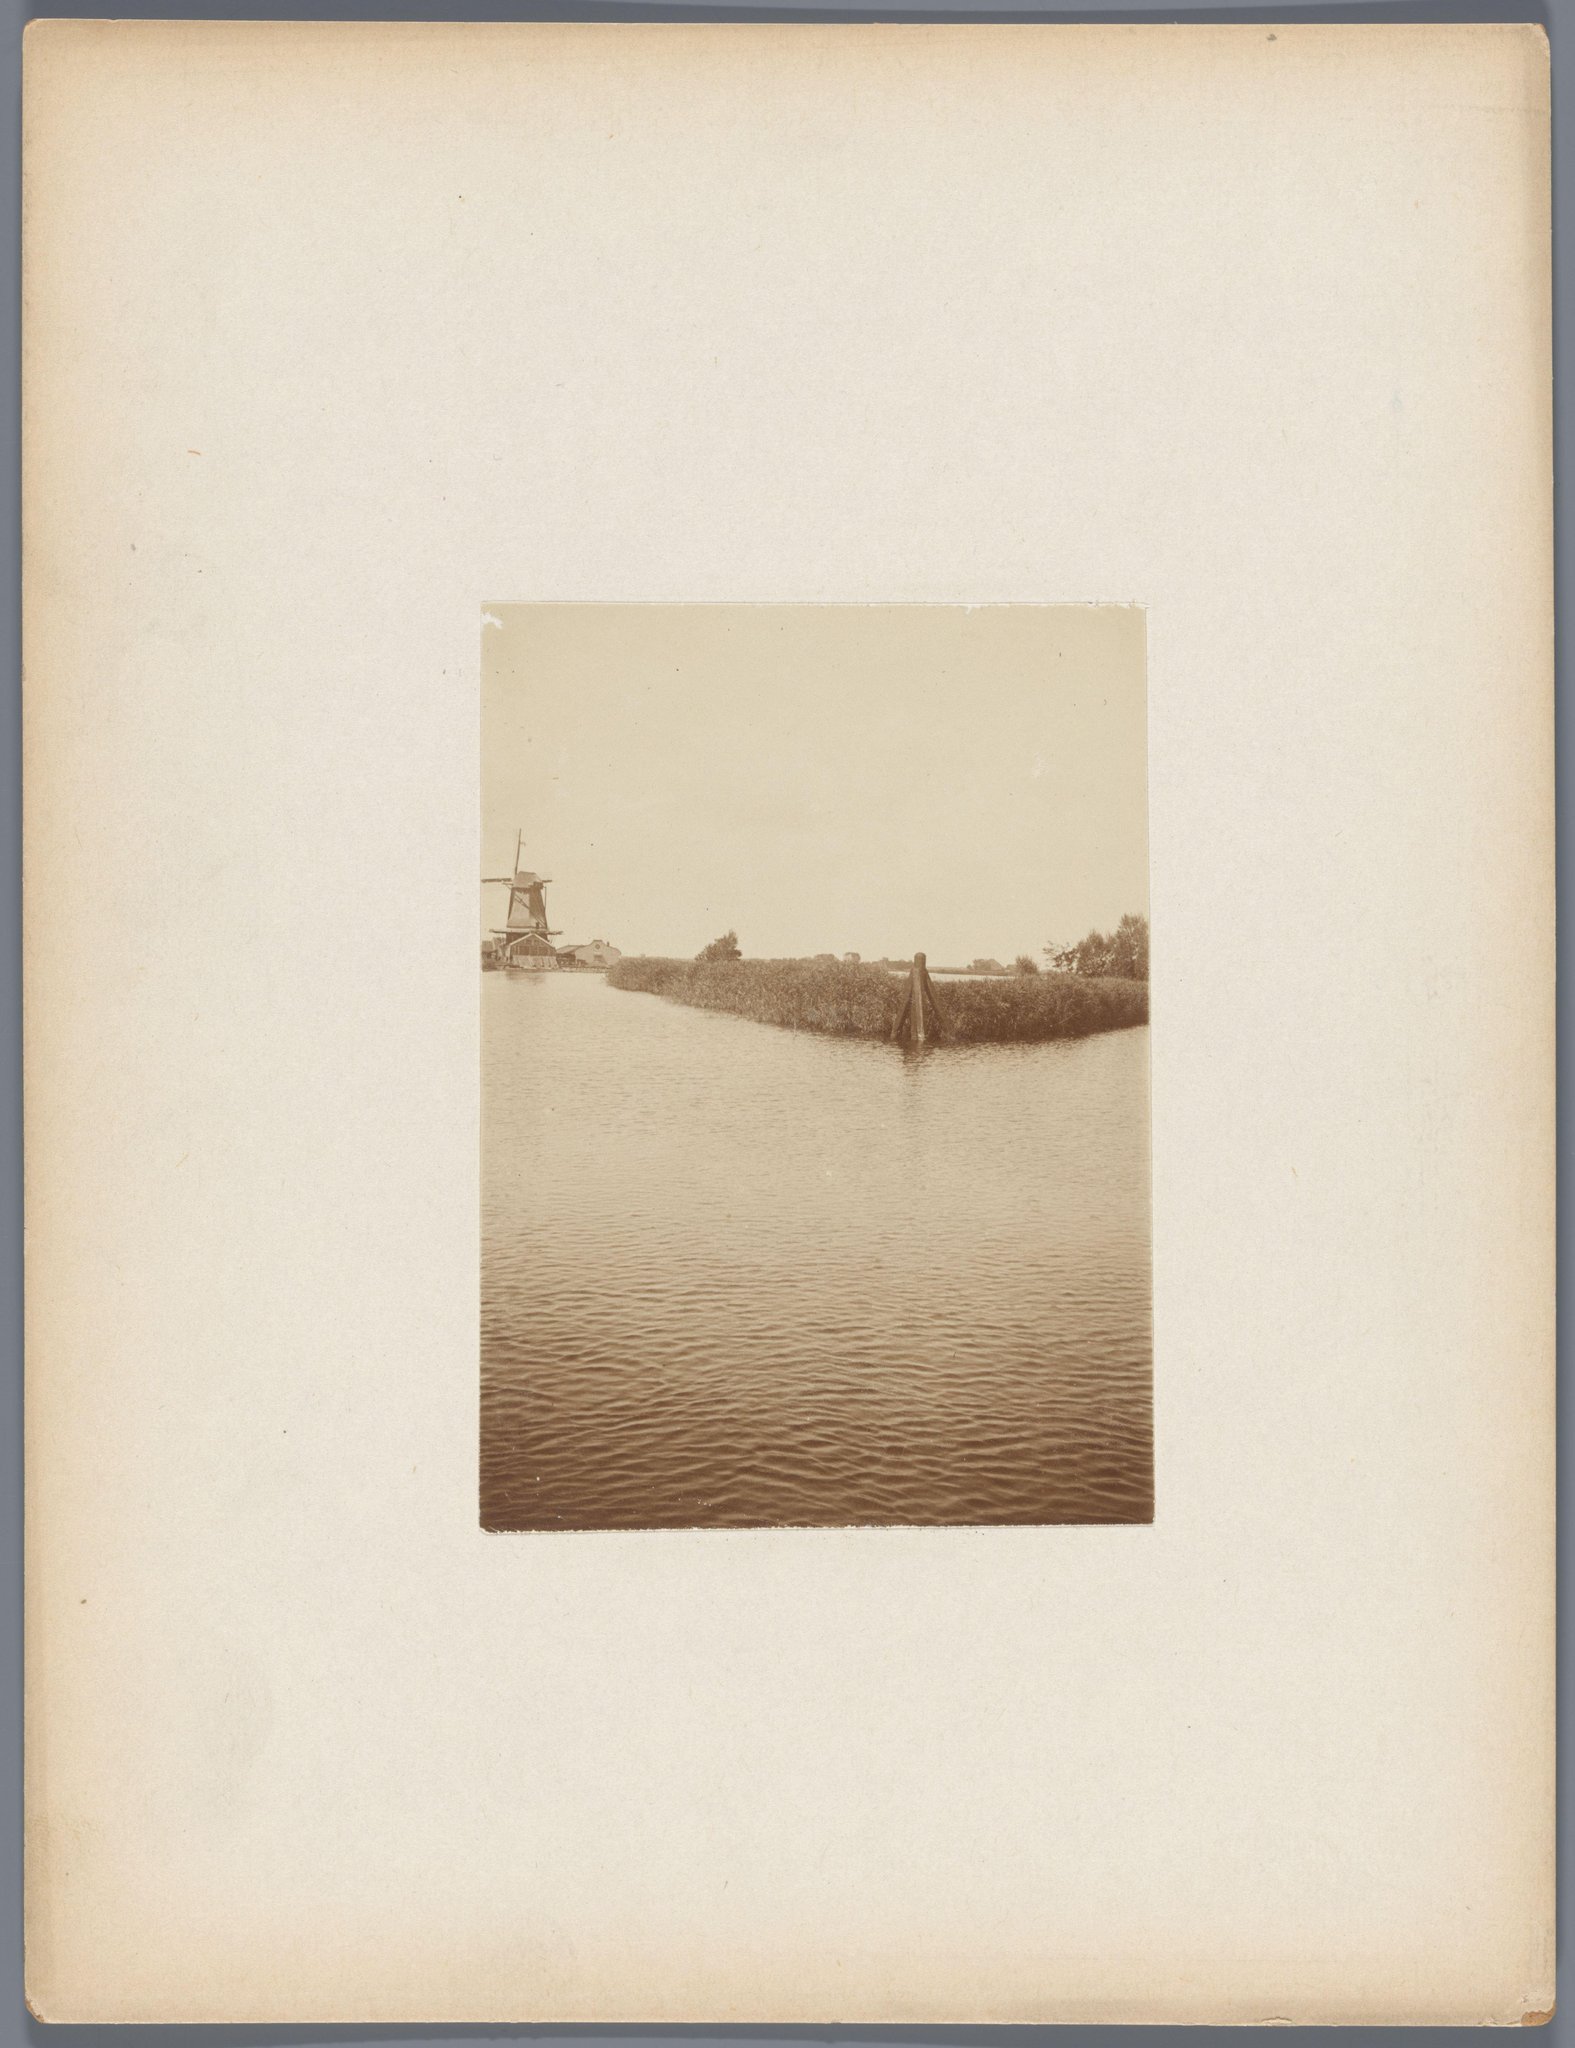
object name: photograph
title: Molen aan water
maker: Anonymous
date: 1907-1910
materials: cardboard, photographic support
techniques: collodion silver print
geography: netherlands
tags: windmill in landscape, netherlands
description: Gezicht over het water met een molen en een dukdalf. Onderdeel van het losbladige fotoalbum met 39 foto's van een reis door Nederland, ca. 1907-1910.